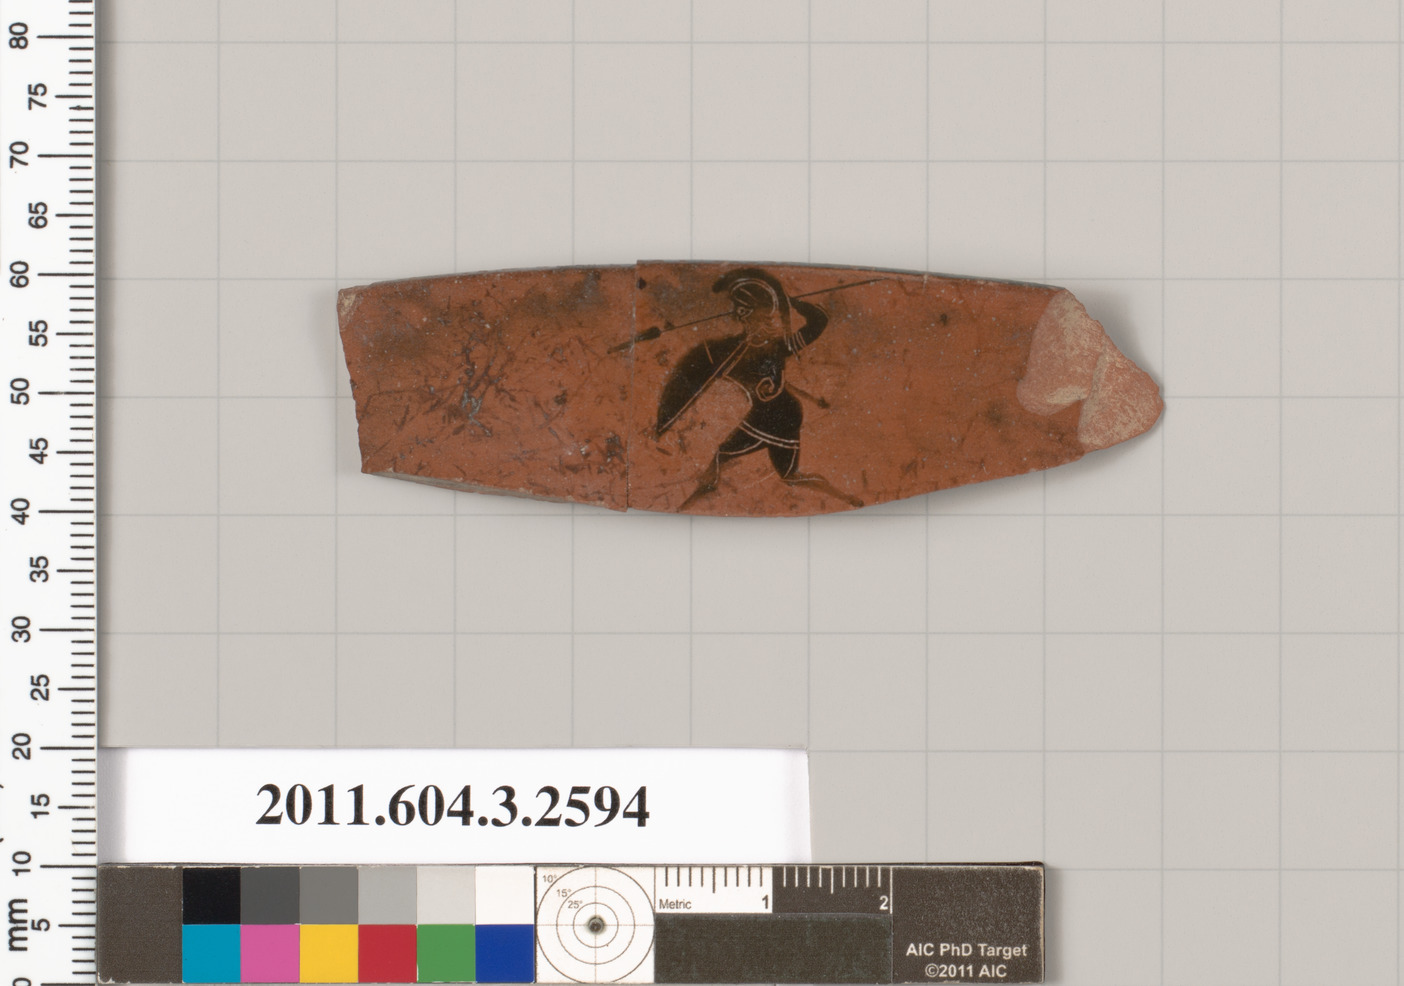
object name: kylix fragment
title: Terracotta rim fragment of a kylix: lip-cup (drinking cup)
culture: greek, attic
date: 550-526 BCE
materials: terracotta